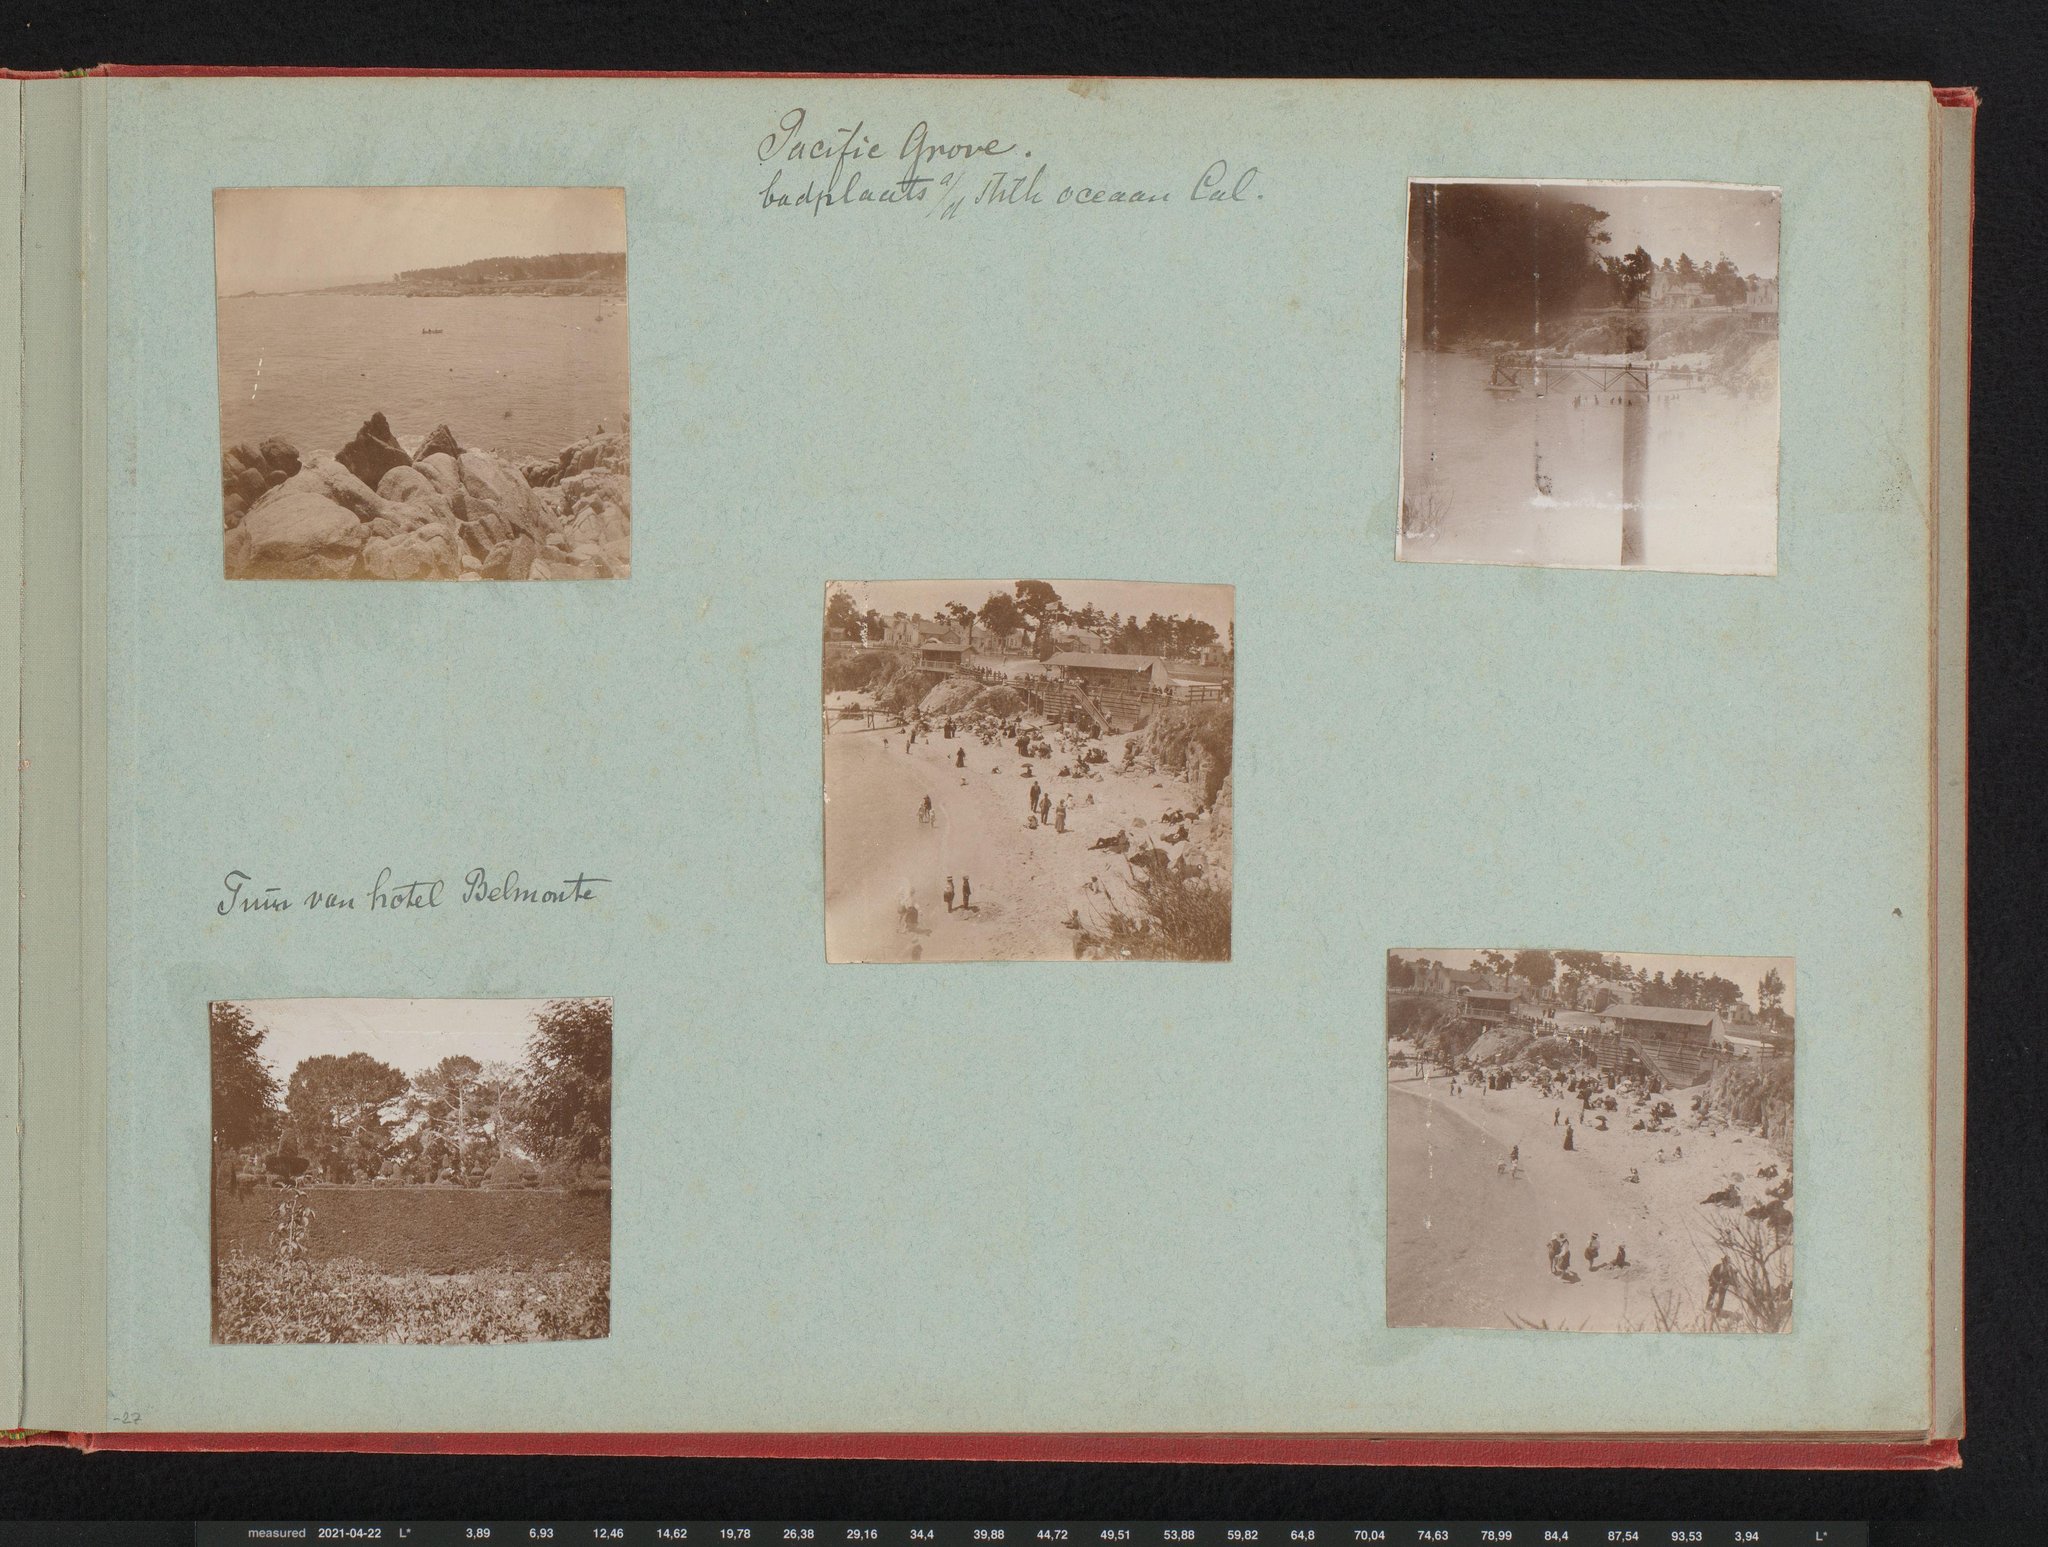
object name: photograph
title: Gezichten aan de kust van Pacific Grove, Californië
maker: Anonymous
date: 1898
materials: paper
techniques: collodion silver print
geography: pacific grove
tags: beach (as place of recreation)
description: Deze foto's zijn onderdeel van een album.